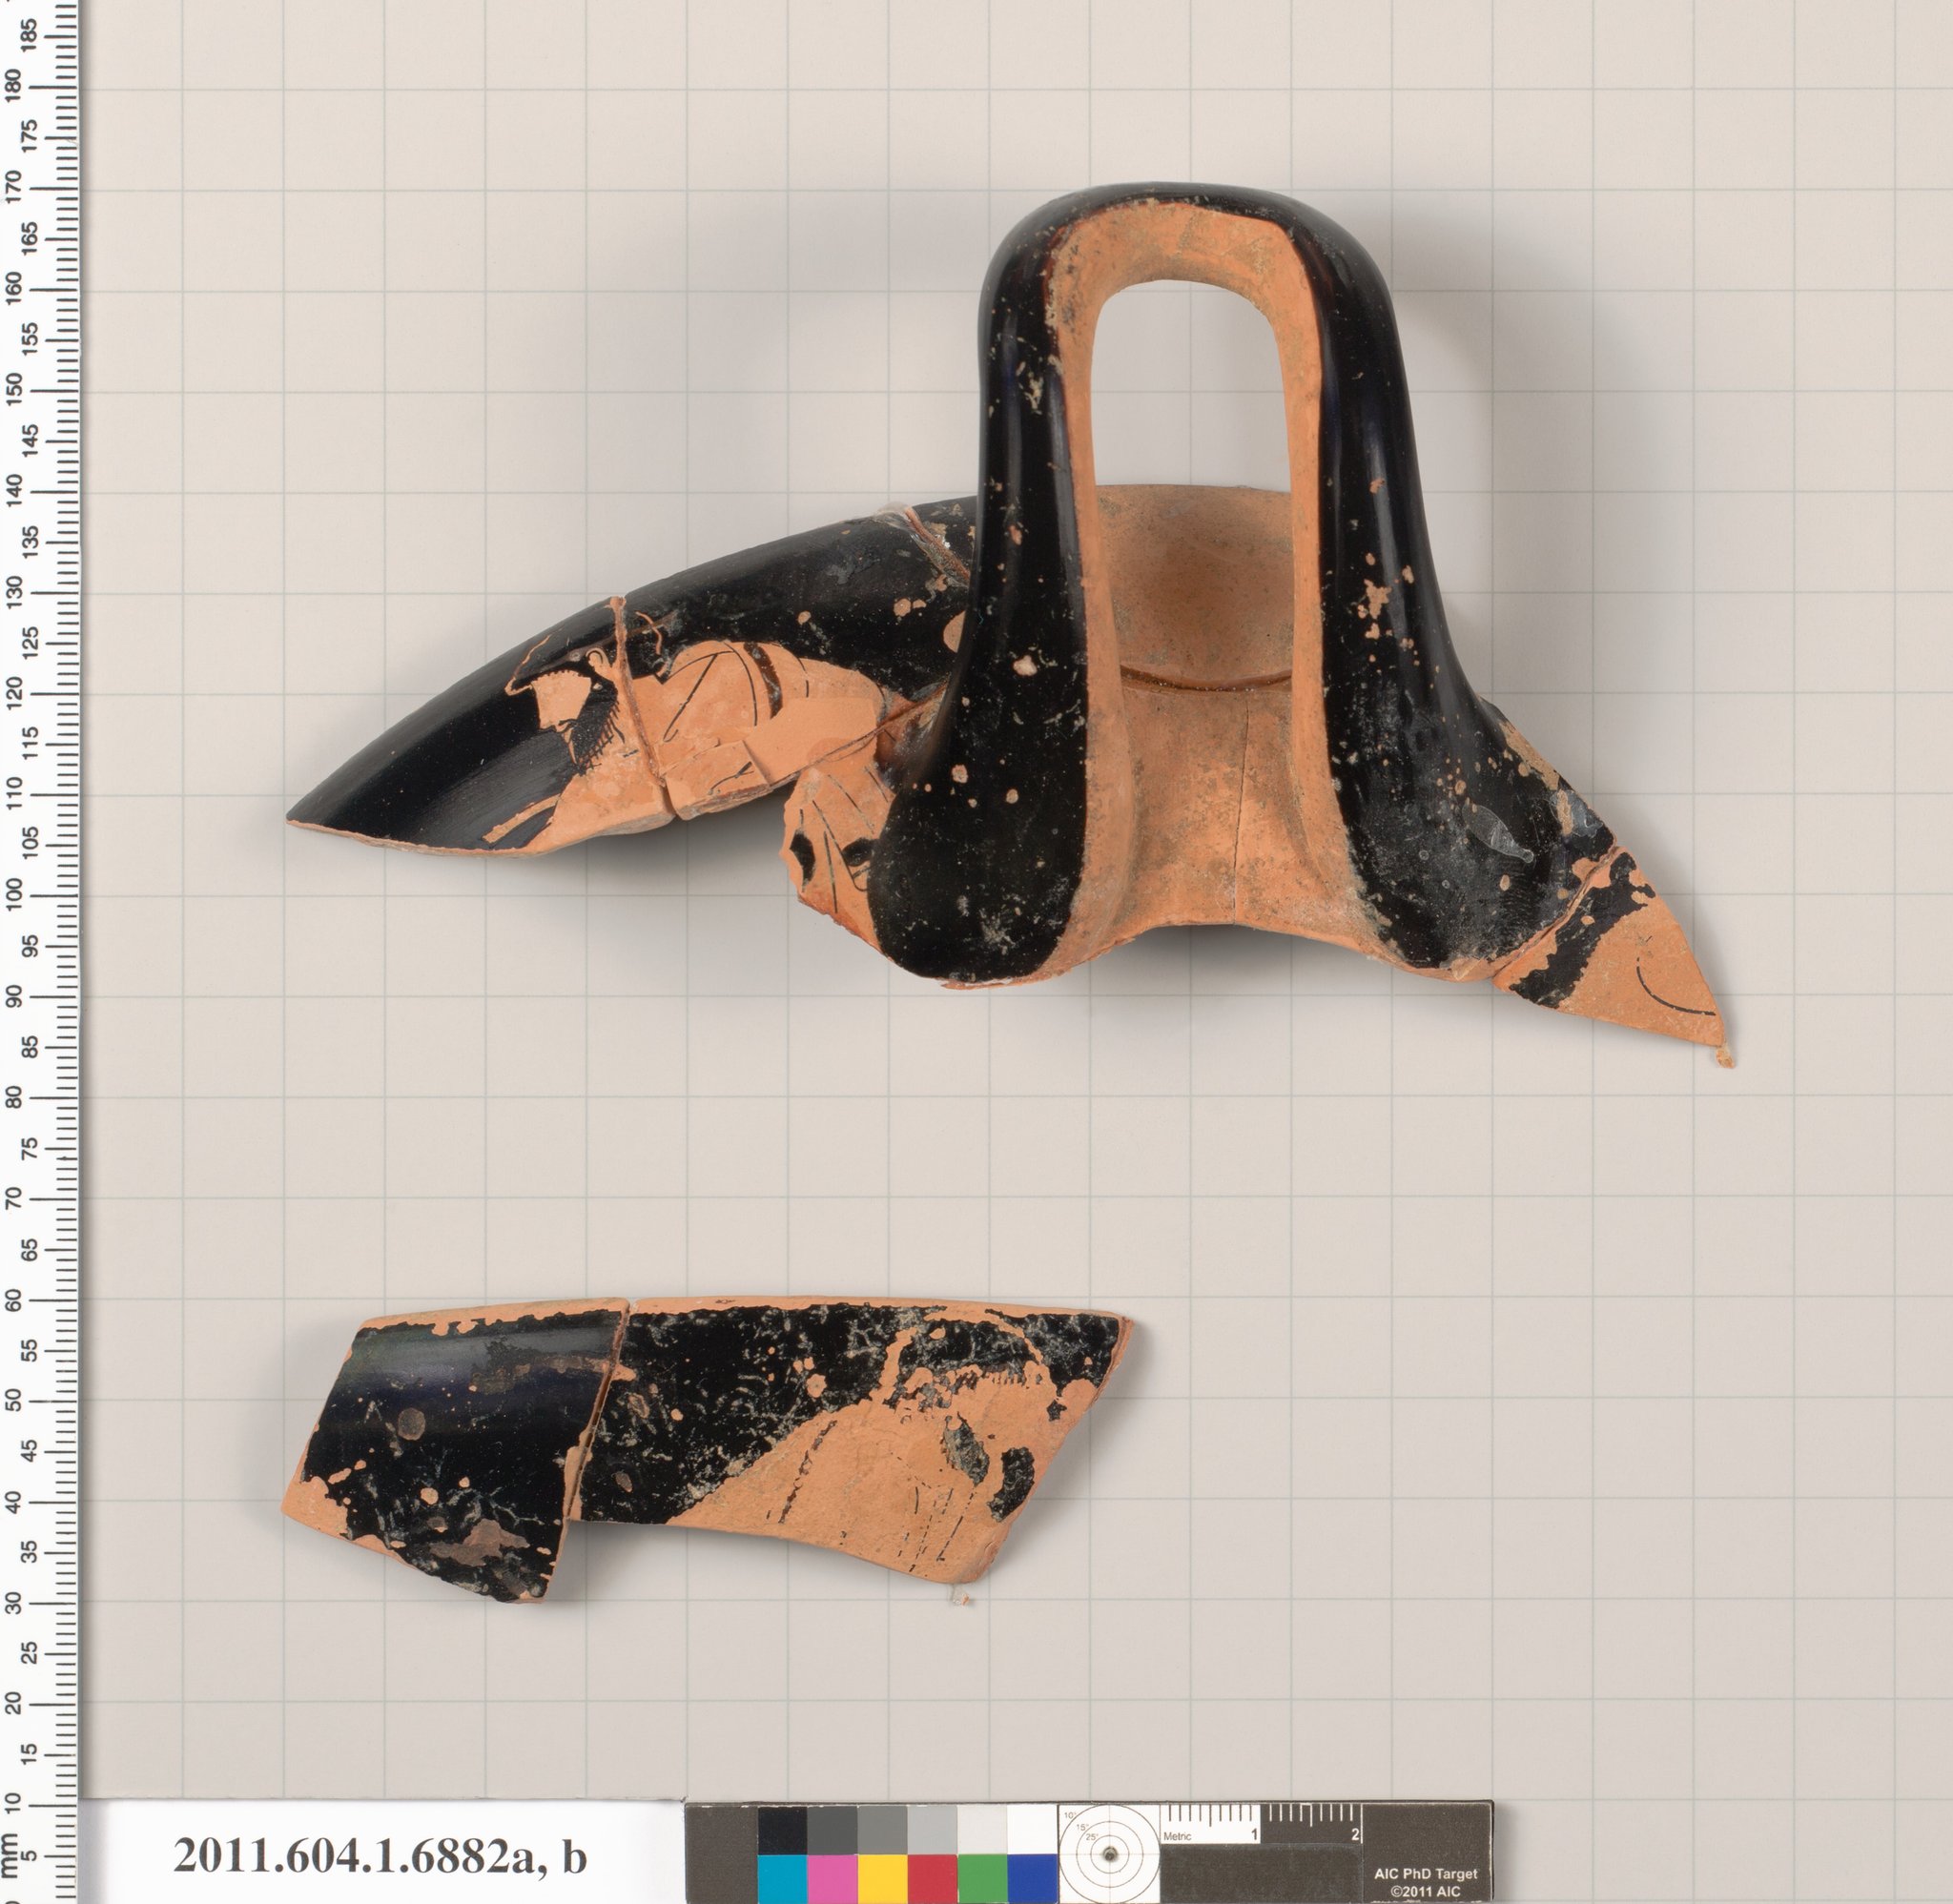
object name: kylix fragment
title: Terracotta rim fragments of a kylix (drinking cup)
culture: greek, attic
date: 490-470 BCE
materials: terracotta